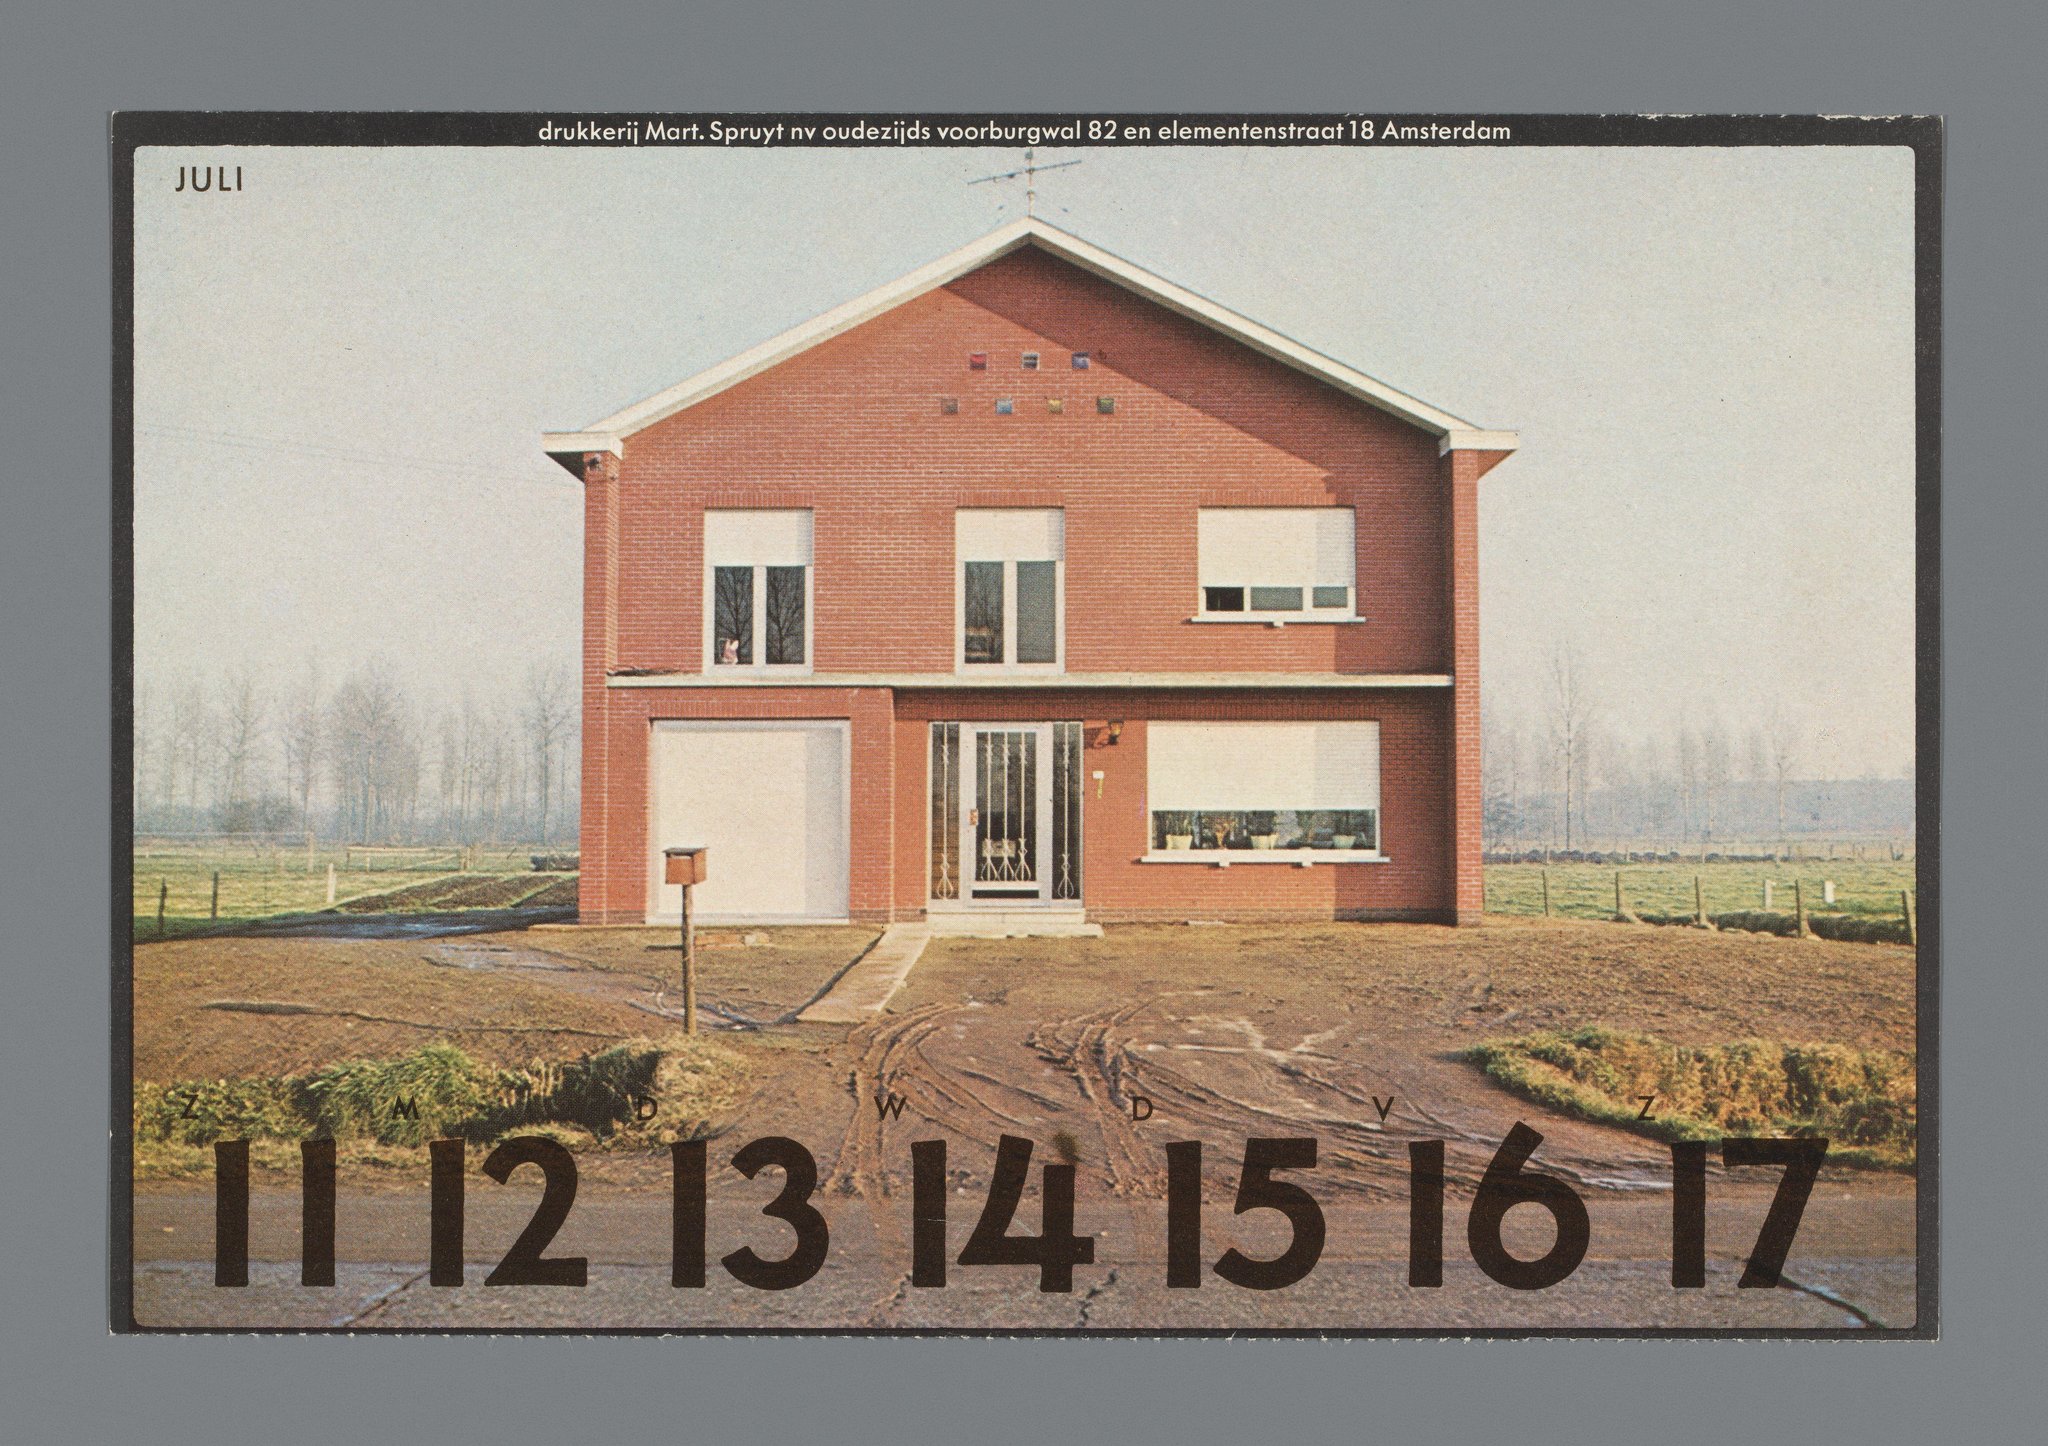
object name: photograph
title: België. Huizen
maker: Anonymous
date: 1900-1950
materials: paper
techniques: offset printed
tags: belgium